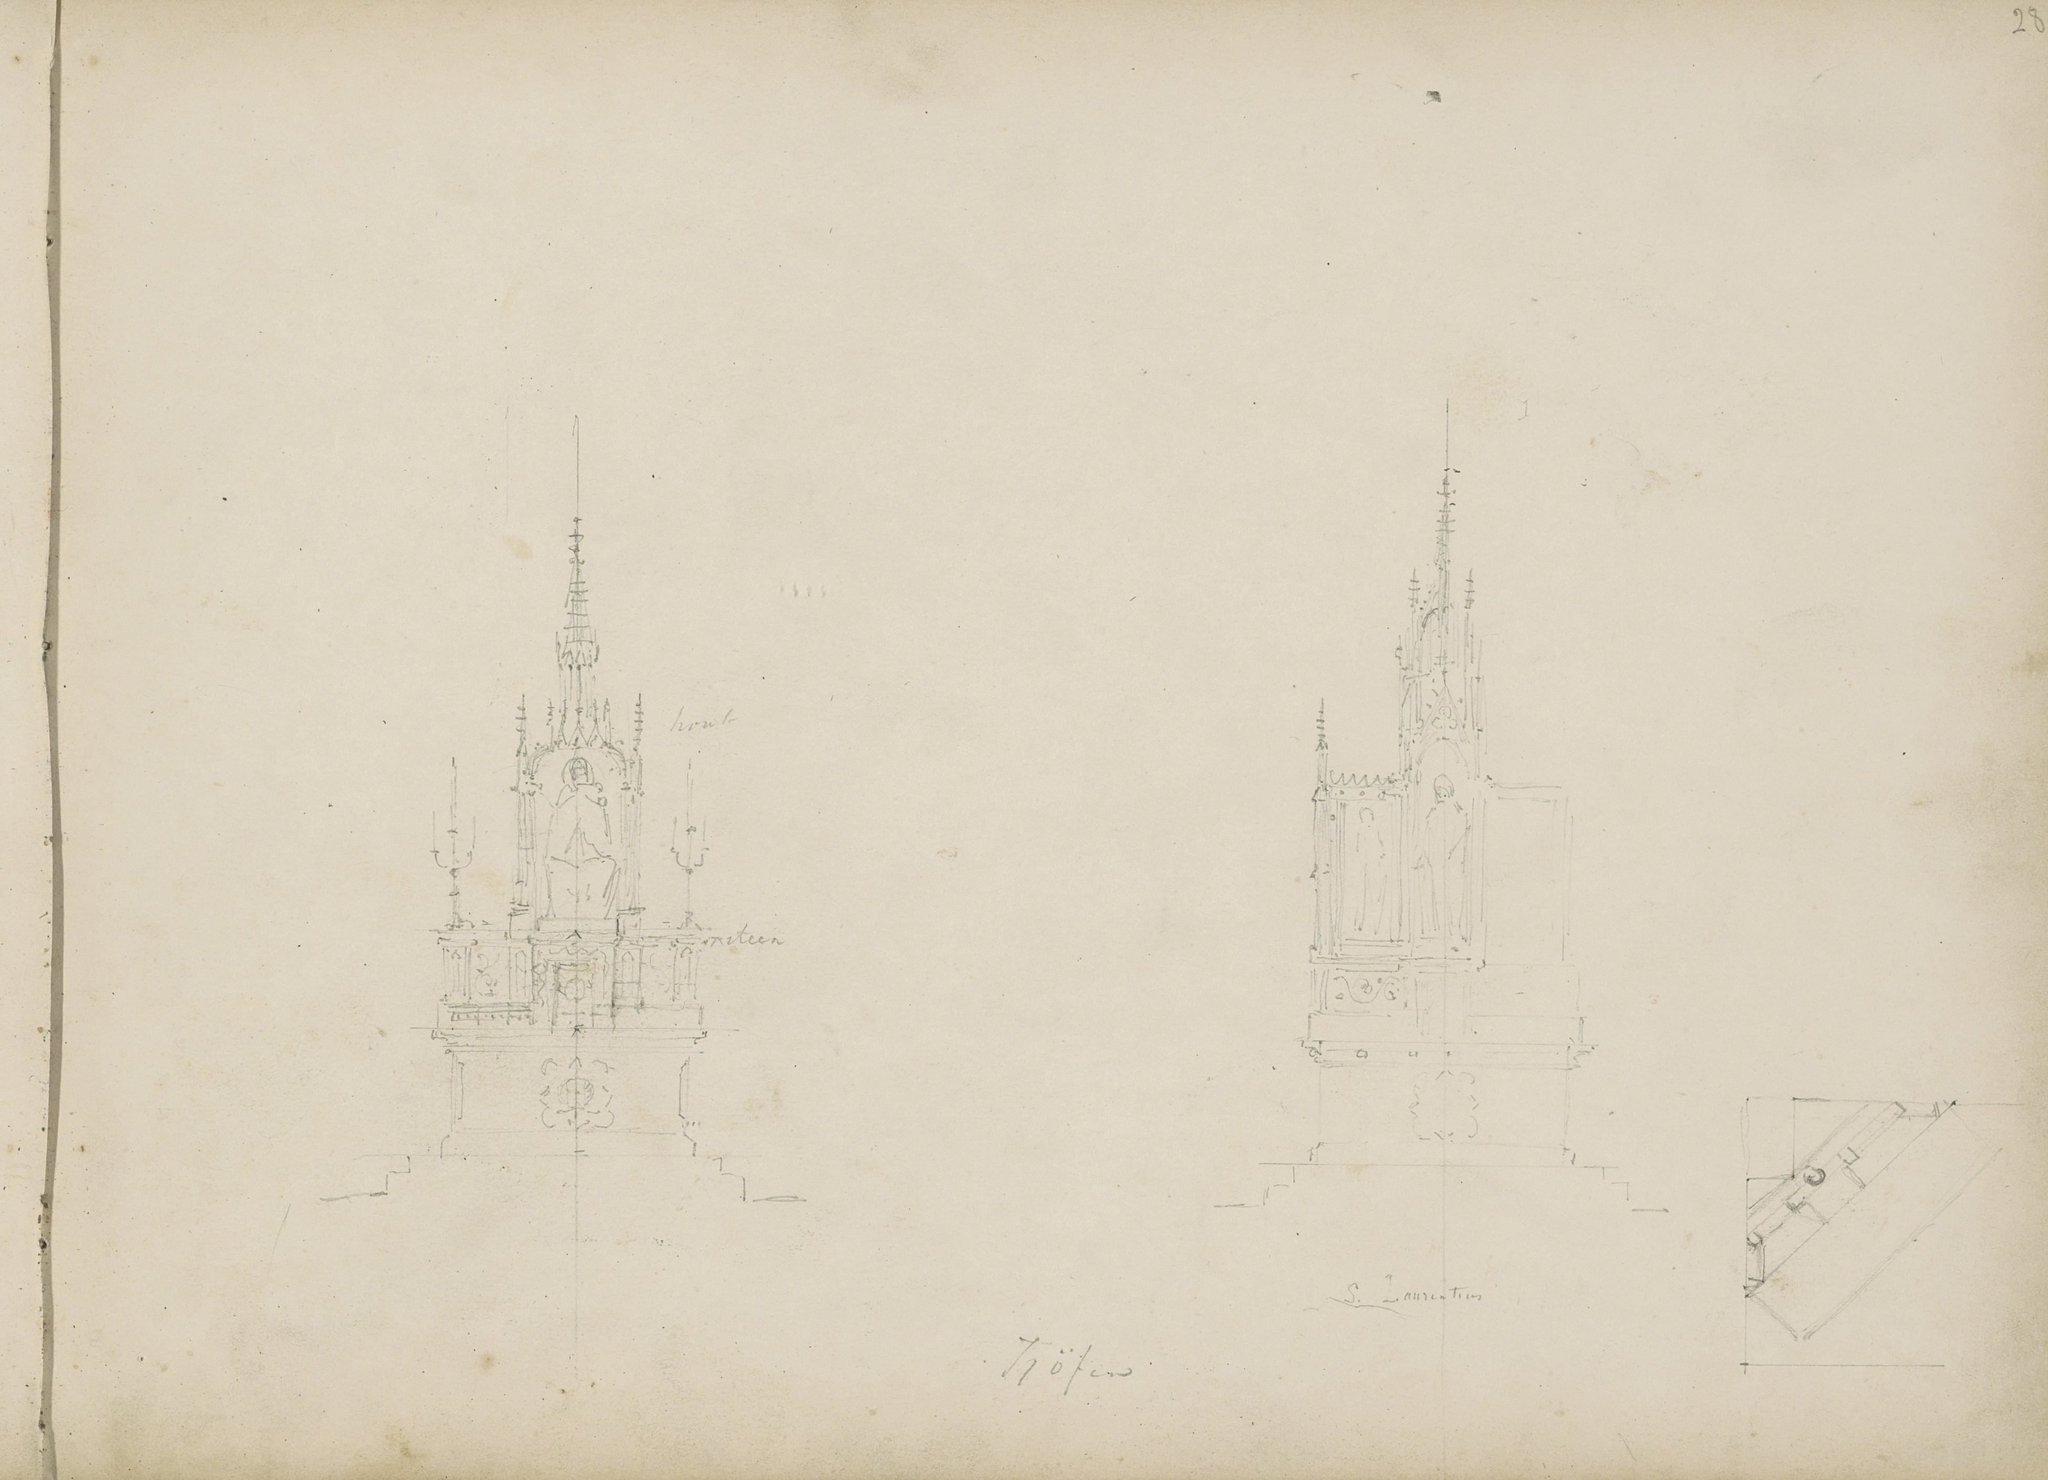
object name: sketchbook leaf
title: Altaren, Höfen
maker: pierre joseph hubert cuypers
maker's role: draughtsman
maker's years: 1827-1921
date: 1857-1859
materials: paper, pencil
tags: altar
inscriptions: annotation: ‘Höfen/ S. Laurentius’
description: Titel gebaseerd op annotatie en inhoudsopgave door Cuypers op blad 77 recto.